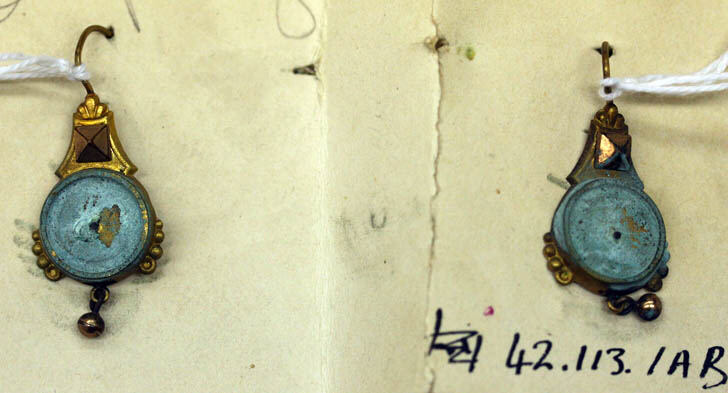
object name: earring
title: Earrings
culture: american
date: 1870-1890